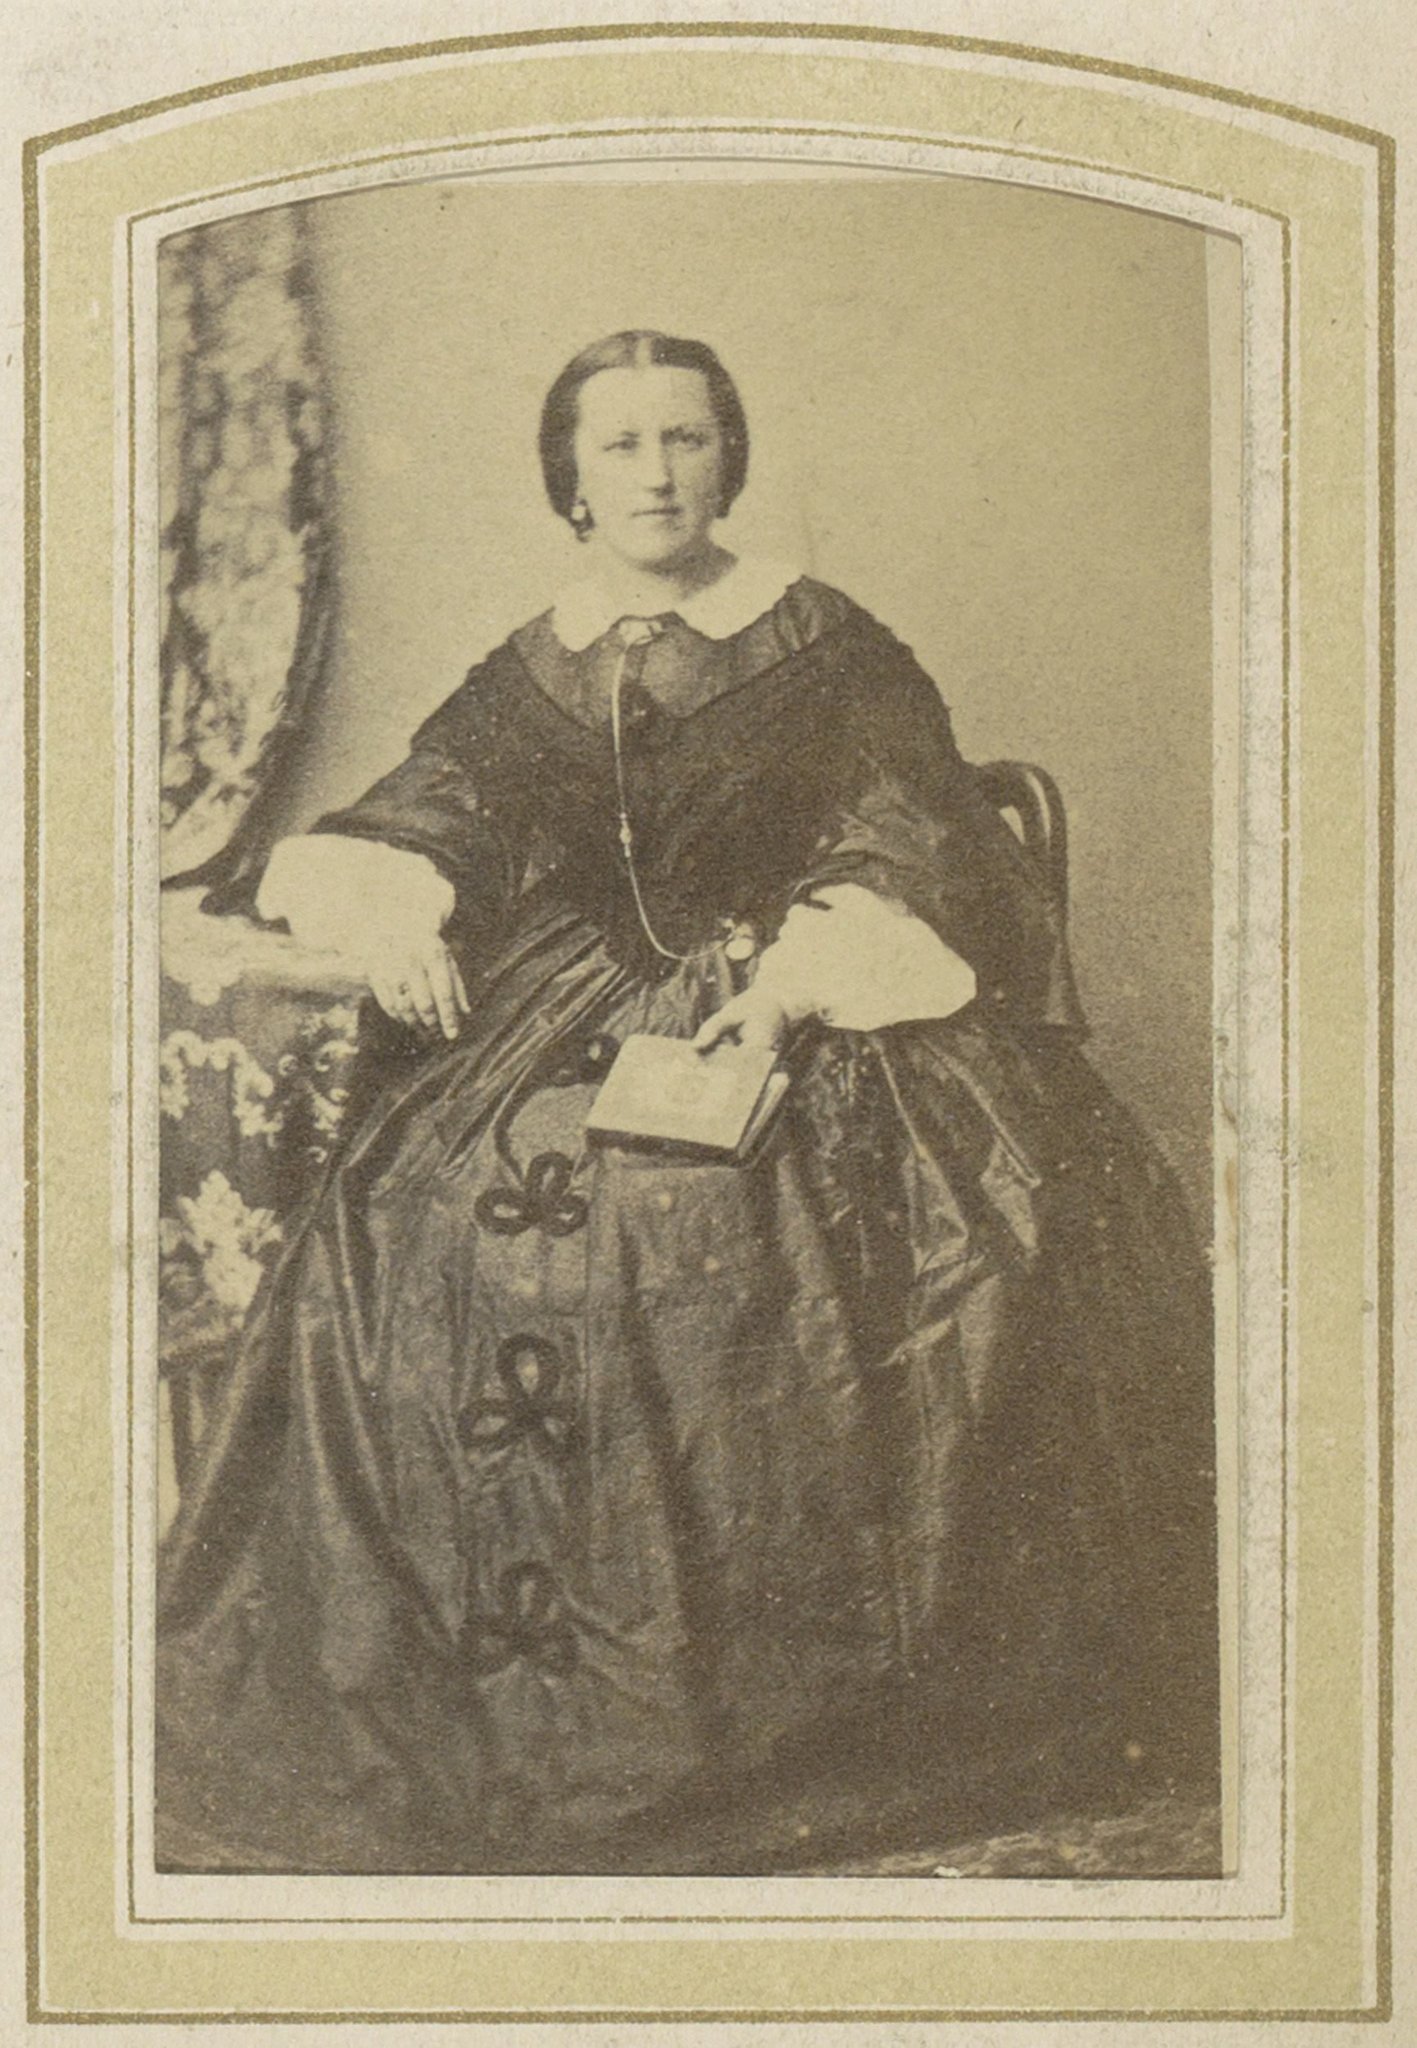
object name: carte de visite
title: Portret van een zittende vrouw in een jurk met een boek in de hand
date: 1860-1900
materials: cardboard, paper, photographic support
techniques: albumen print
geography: london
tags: studio requisites ~ photographer, clothing for the lower part of the body, historical persons, clothing for the upper part of the body, book, london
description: Onderdeel van Fotoalbum van een Nederlandse familie met 168 cartes-de-visite en kabinetfoto's.